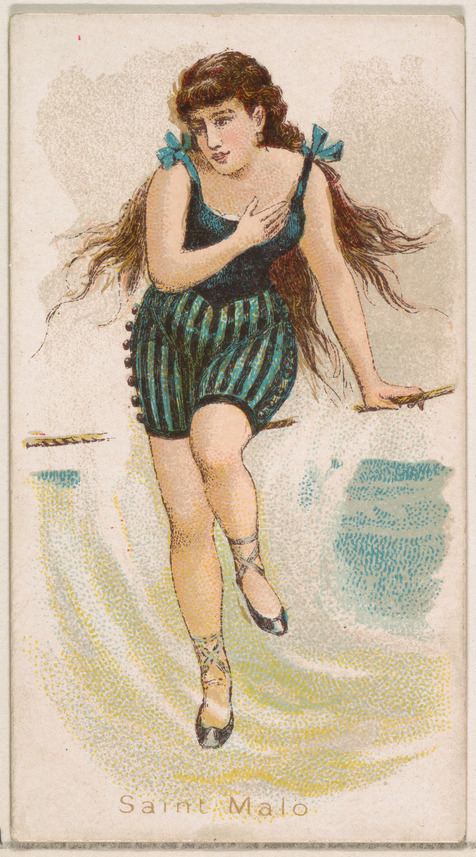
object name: print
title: Saint Malo, from the Fancy Bathers series (N187) issued by Wm. S. Kimball & Co.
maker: william s. kimball & company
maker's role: publisher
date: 1889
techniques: color lithograph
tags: women